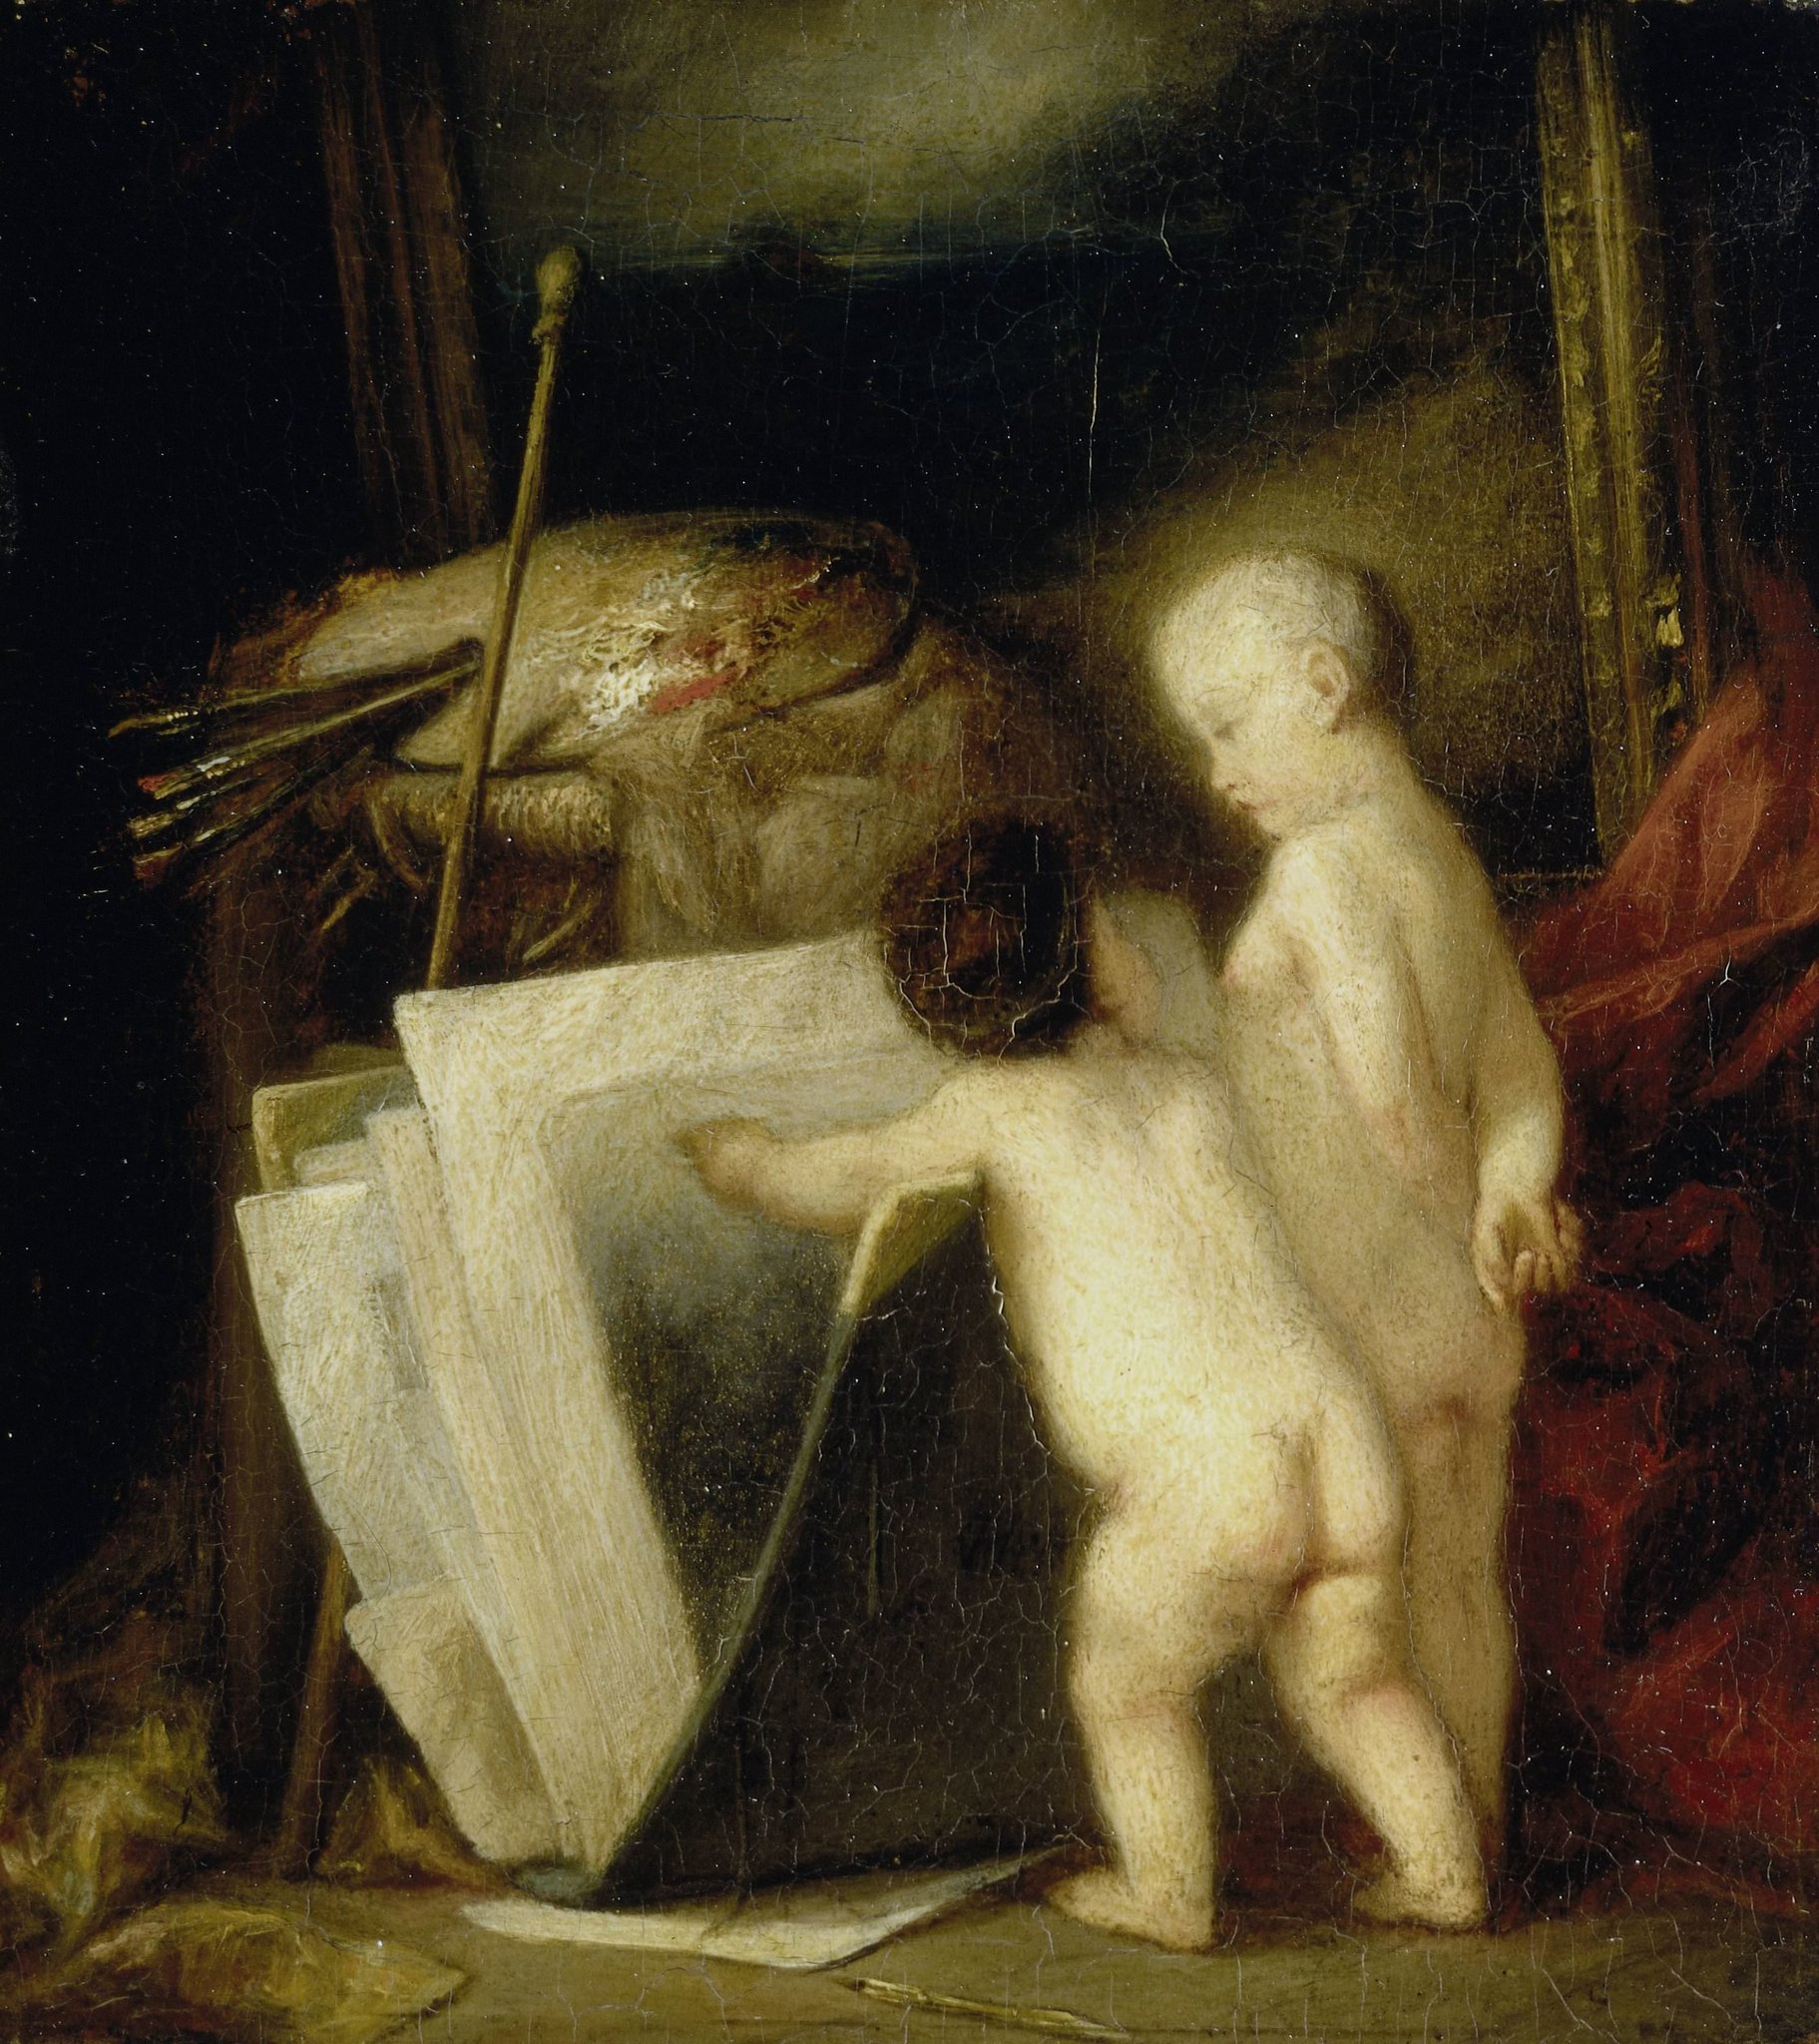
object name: painting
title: De kleine kunstliefhebbers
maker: hippolyte michaud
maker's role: painter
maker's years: 1813-1886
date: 1840-1886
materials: oil, panel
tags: criticizing and discussing art, art criticism, drawing, sketch, person stimulating the arts; art lover, connoisseur, maecenas, patron, art collecting, child between toddler and youth (of undetermined sex)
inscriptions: signature: ‘H. Michaud Pinx.’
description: De kleine kunstliefhebbers. In een schildersatelier bekijken twee naakte kindertjes een portefeuille met tekeningen. Links een palet met penselen, tegen de muur een groot schilderij.